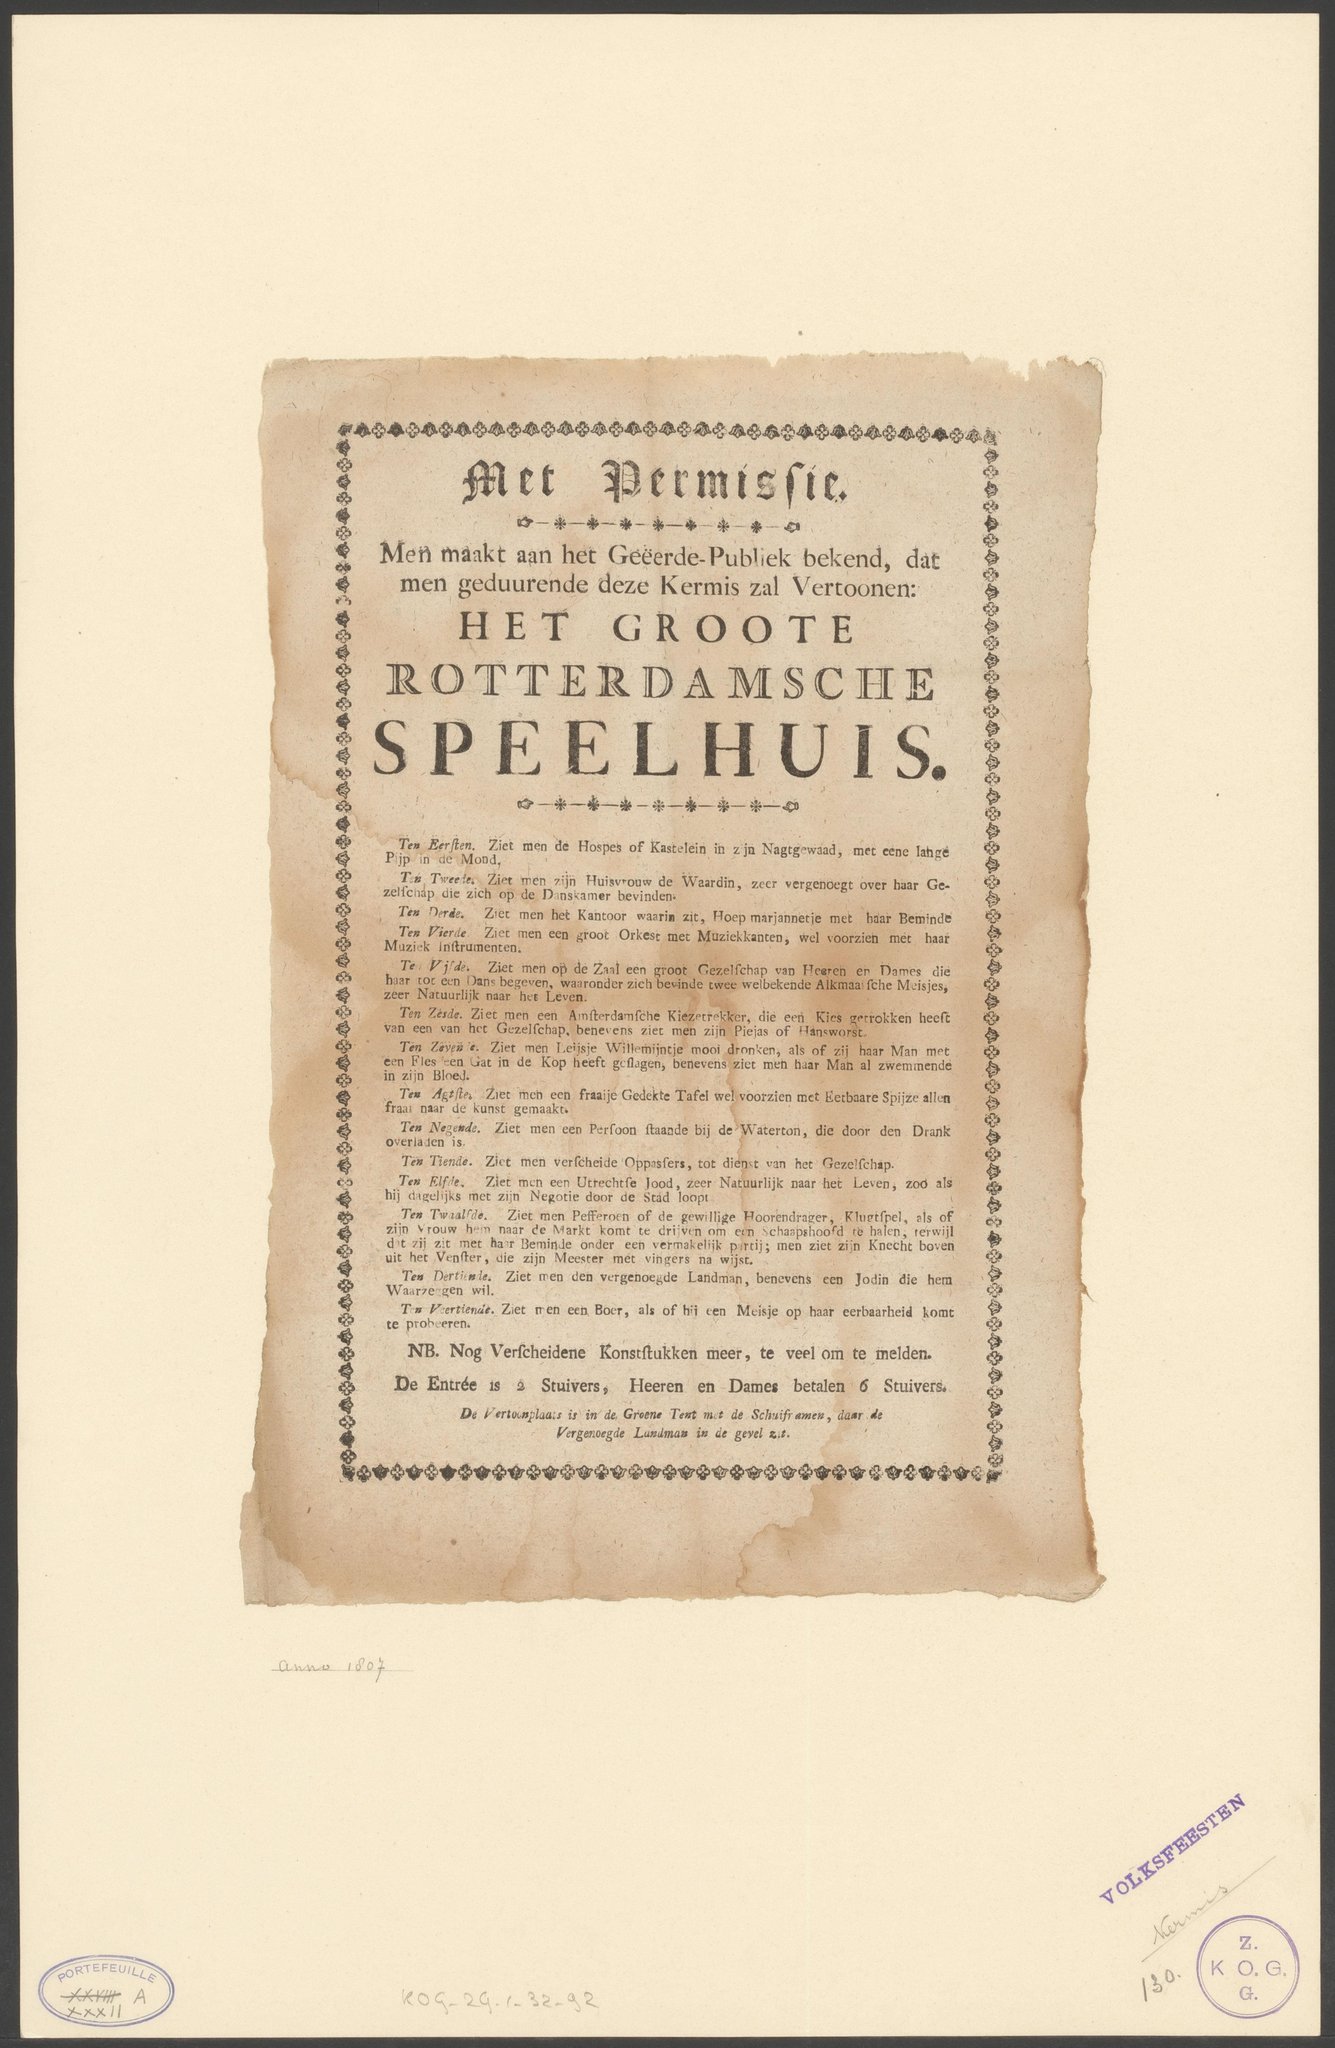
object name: text sheet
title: Het Groote Rotterdamsche Speelhuis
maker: Anonymous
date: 1807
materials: paper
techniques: letterpress printing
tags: wax-figure cabinet, pleasure fair and circus, amsterdam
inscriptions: collector's mark: Lugt 1641, collector's mark